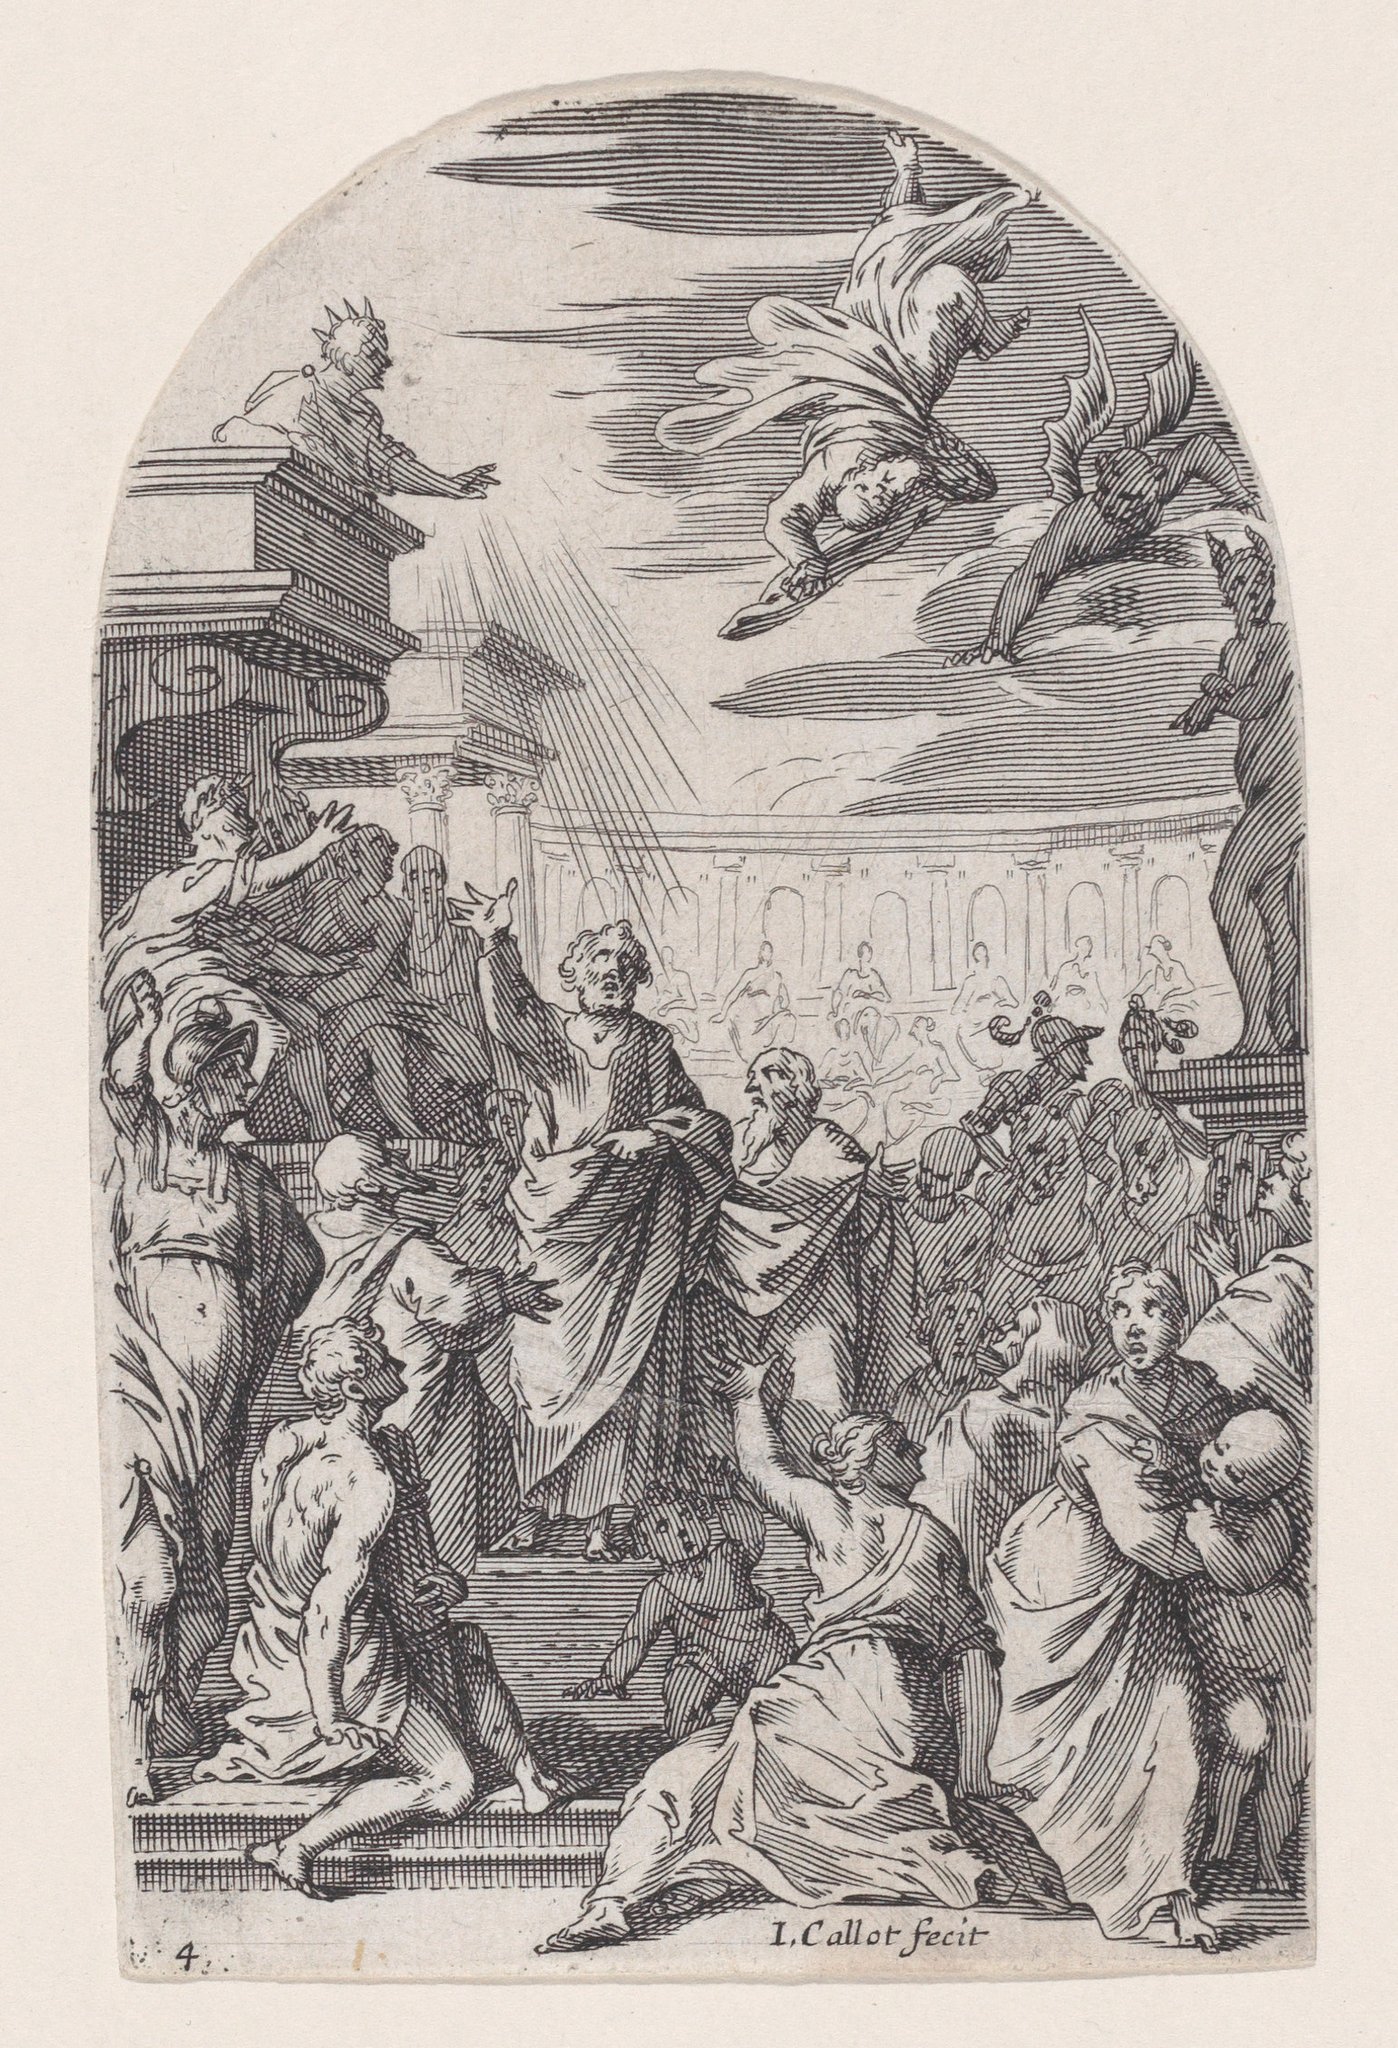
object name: print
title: The Fall of Simon the Magician, plate 4 from "Les Tableaux de Rome, Les Eglises Jubilaires" (The Paintings of Rome, The Churches Jubilee)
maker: jacques callot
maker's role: artist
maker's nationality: french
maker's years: 1592-1635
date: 1607-1611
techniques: engraving